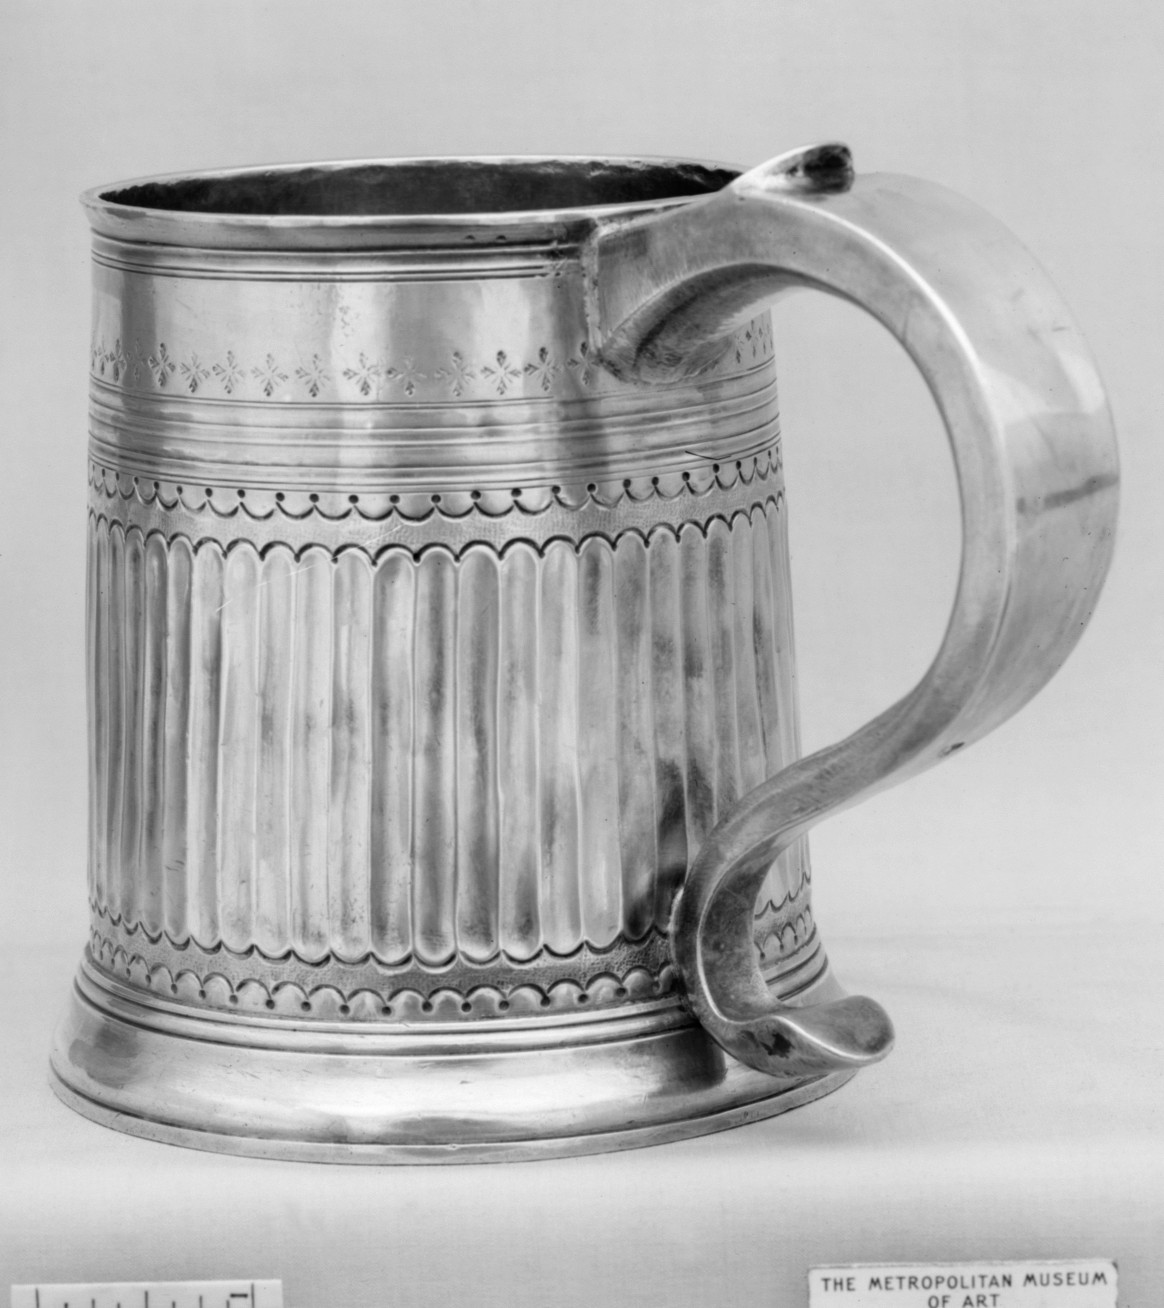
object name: mug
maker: john martin stockar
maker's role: maker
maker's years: 1695-1712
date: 1707-1708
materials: silver